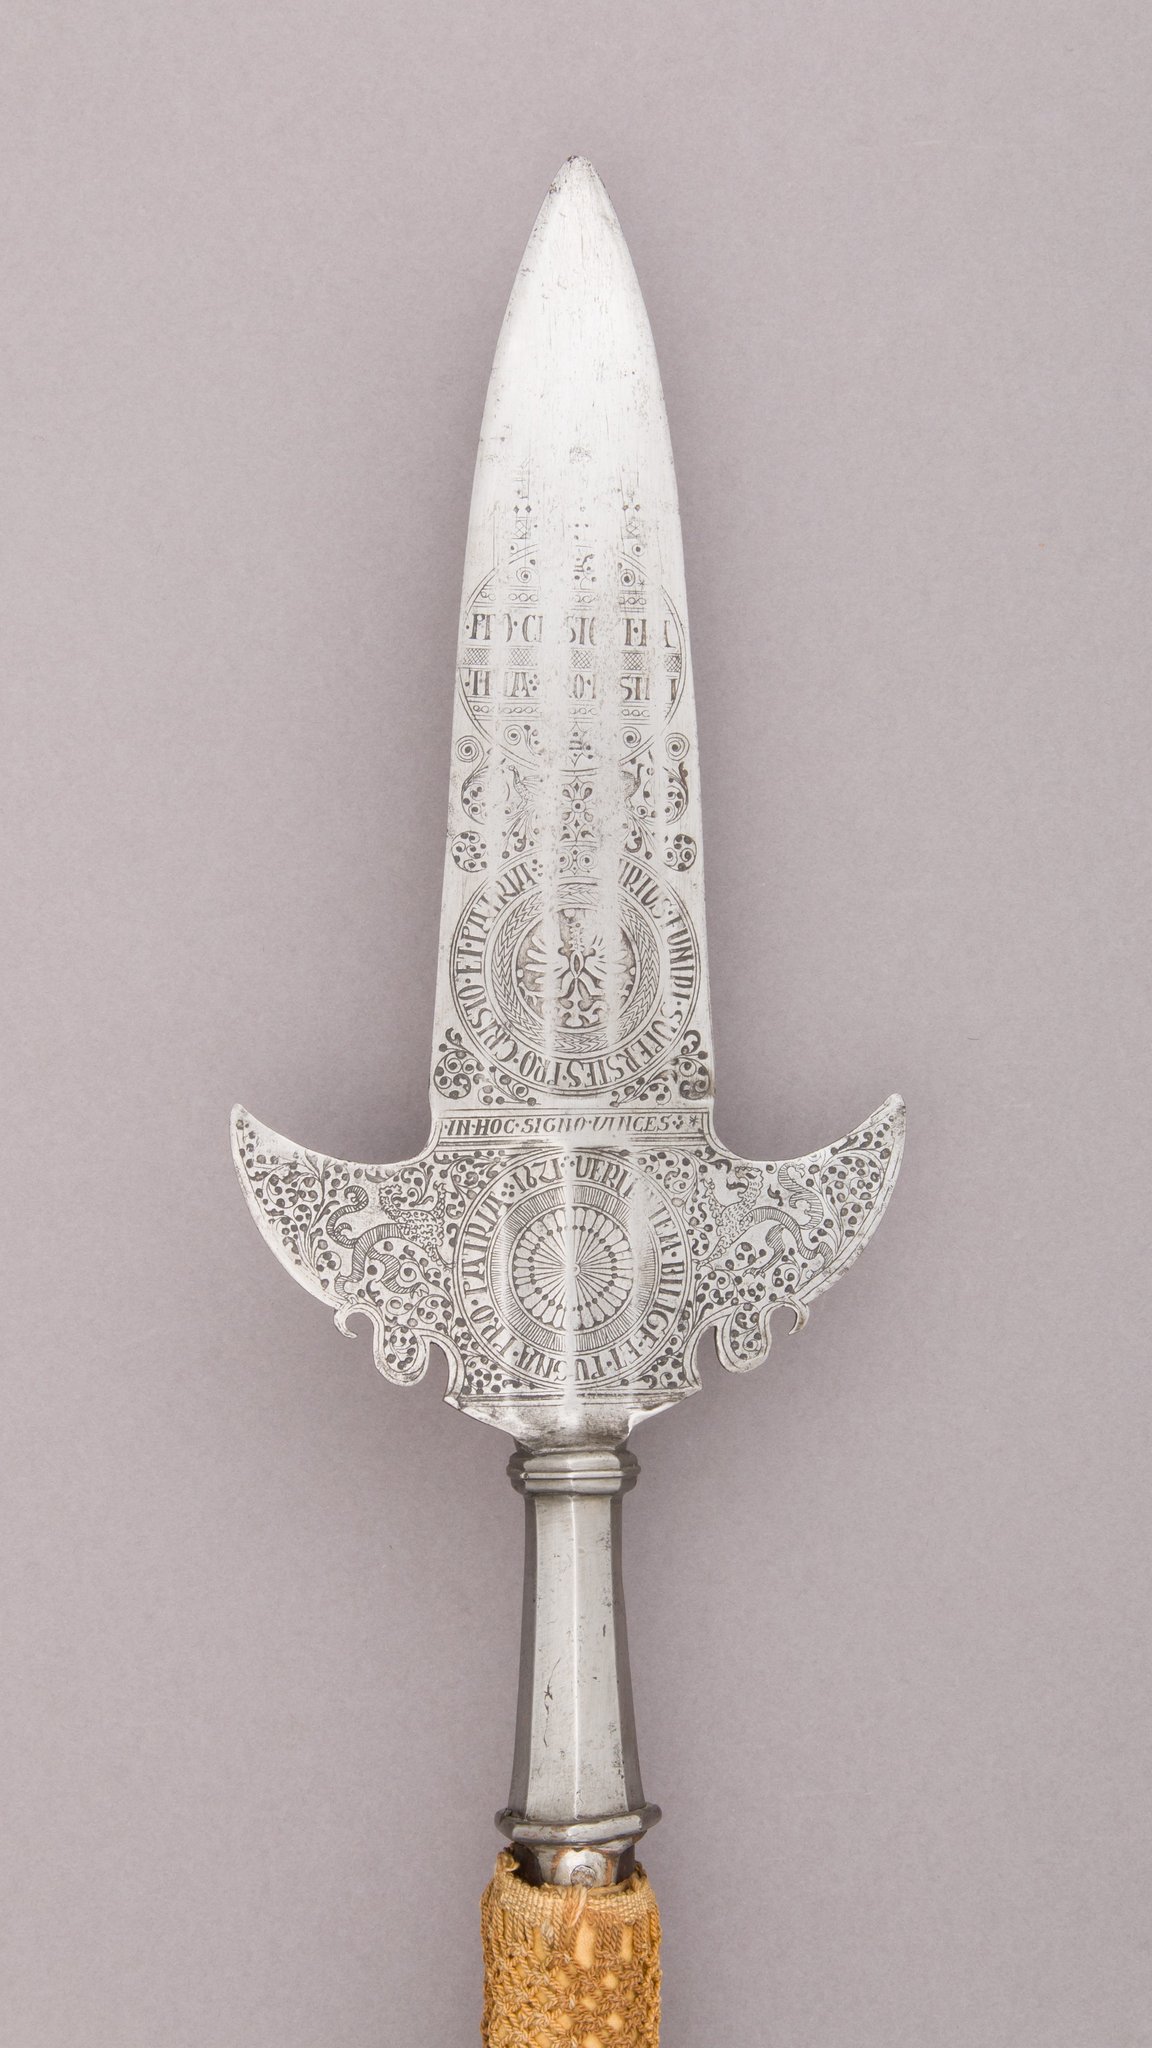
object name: partisan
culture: german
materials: iron, steel, textile, wood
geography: germany